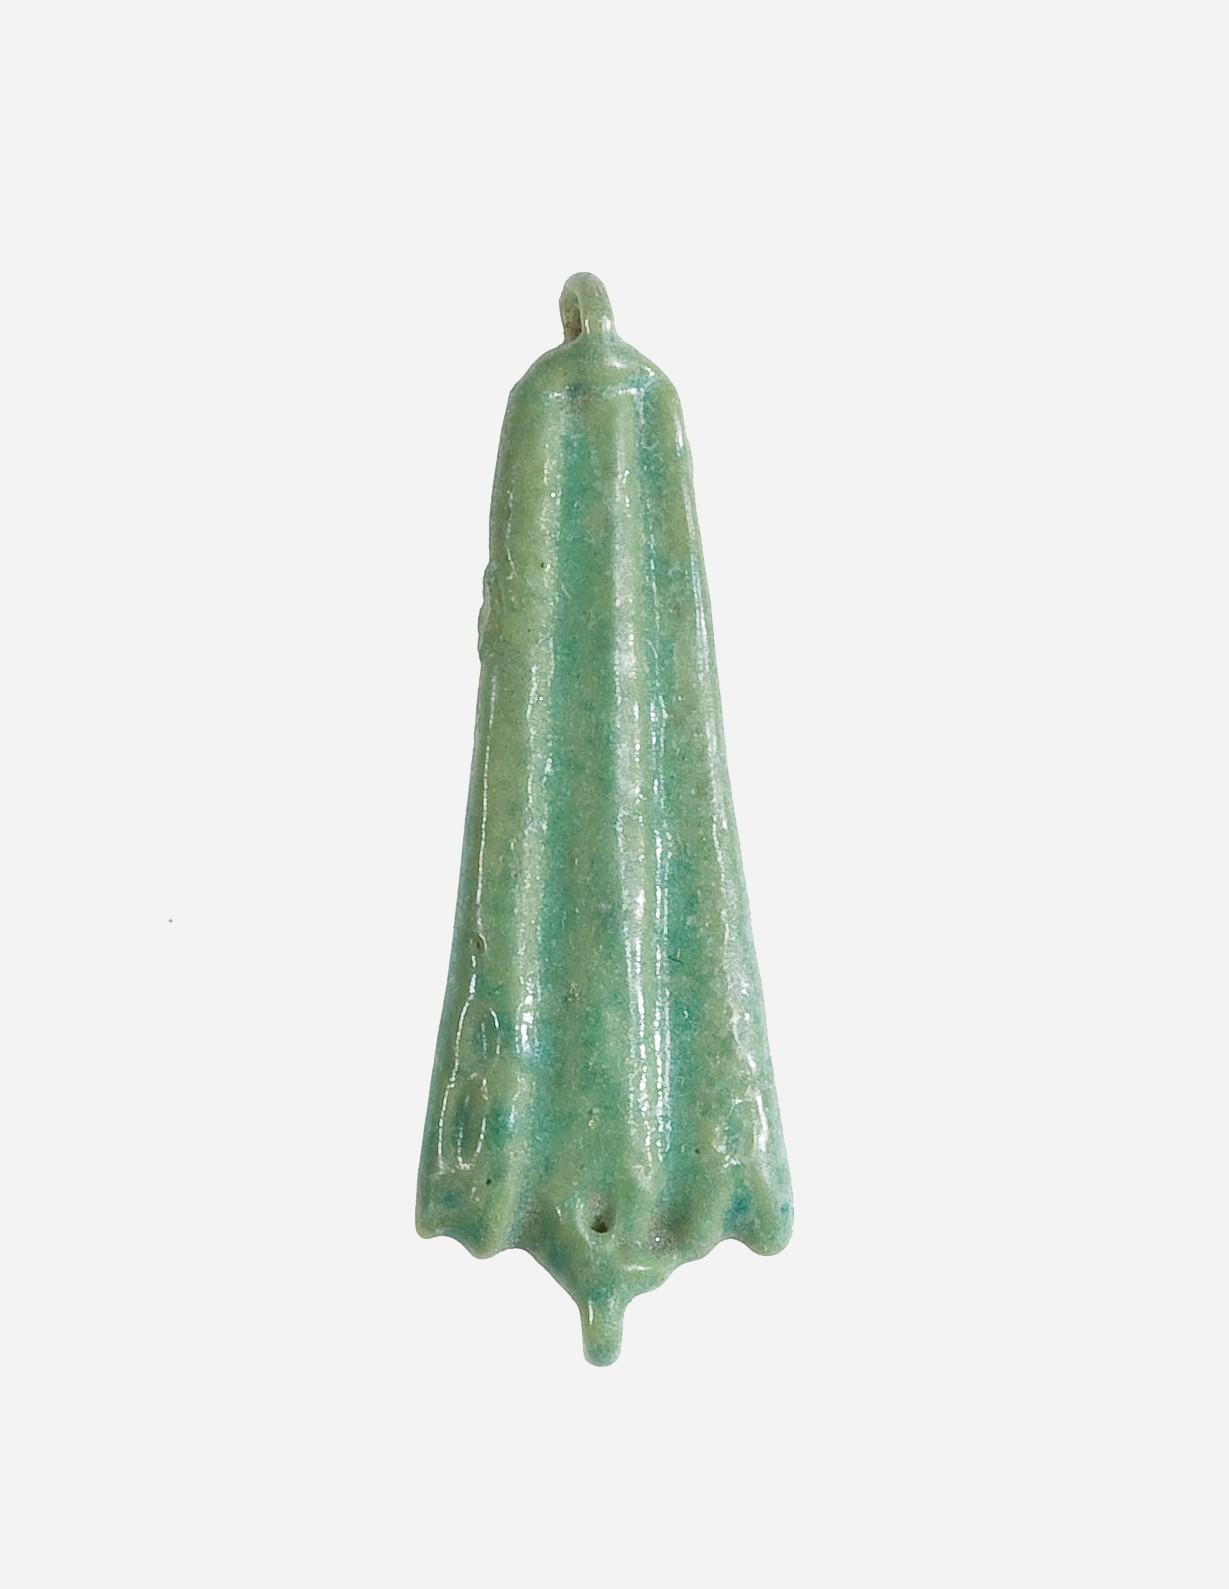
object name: bead, leaf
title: Leaf Bead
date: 1390-1352 BCE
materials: faience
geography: egypt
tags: leaves